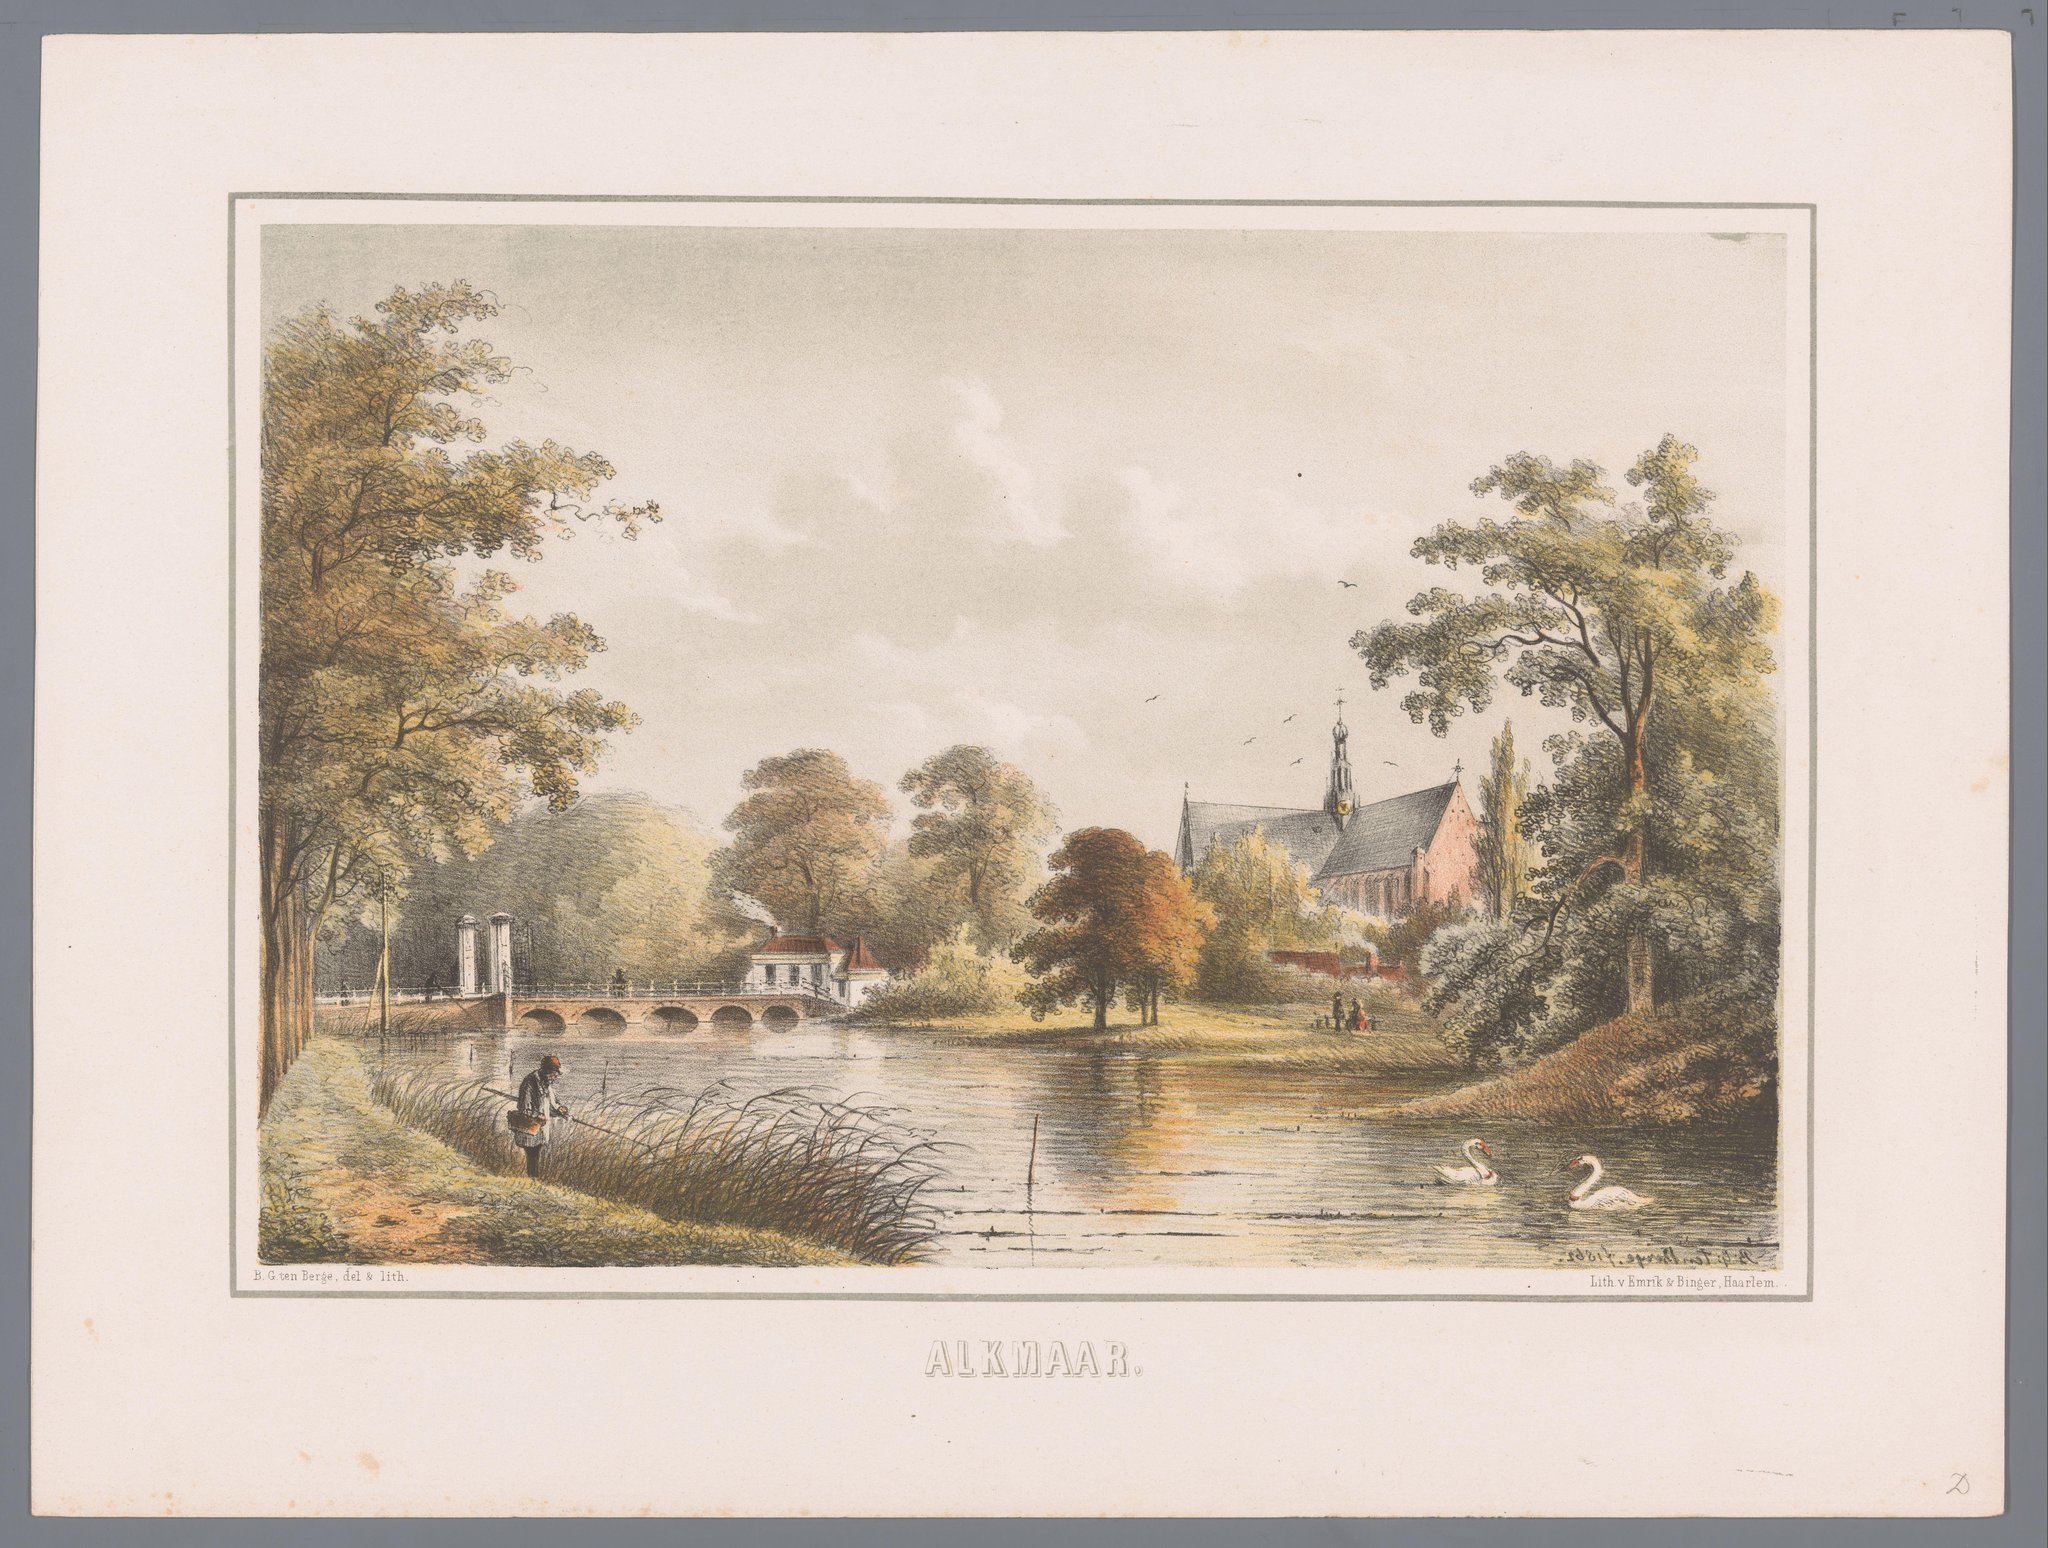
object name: print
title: Stadsgezicht te Alkmaar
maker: bernardus gerardus ten berge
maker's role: draughtsman, print maker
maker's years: 1835-1875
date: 1862-1875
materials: paper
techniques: lithograph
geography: haarlem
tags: city-view, and landscape with man-made constructions, canals, waters (in city)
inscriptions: collector's mark: Lugt 2228